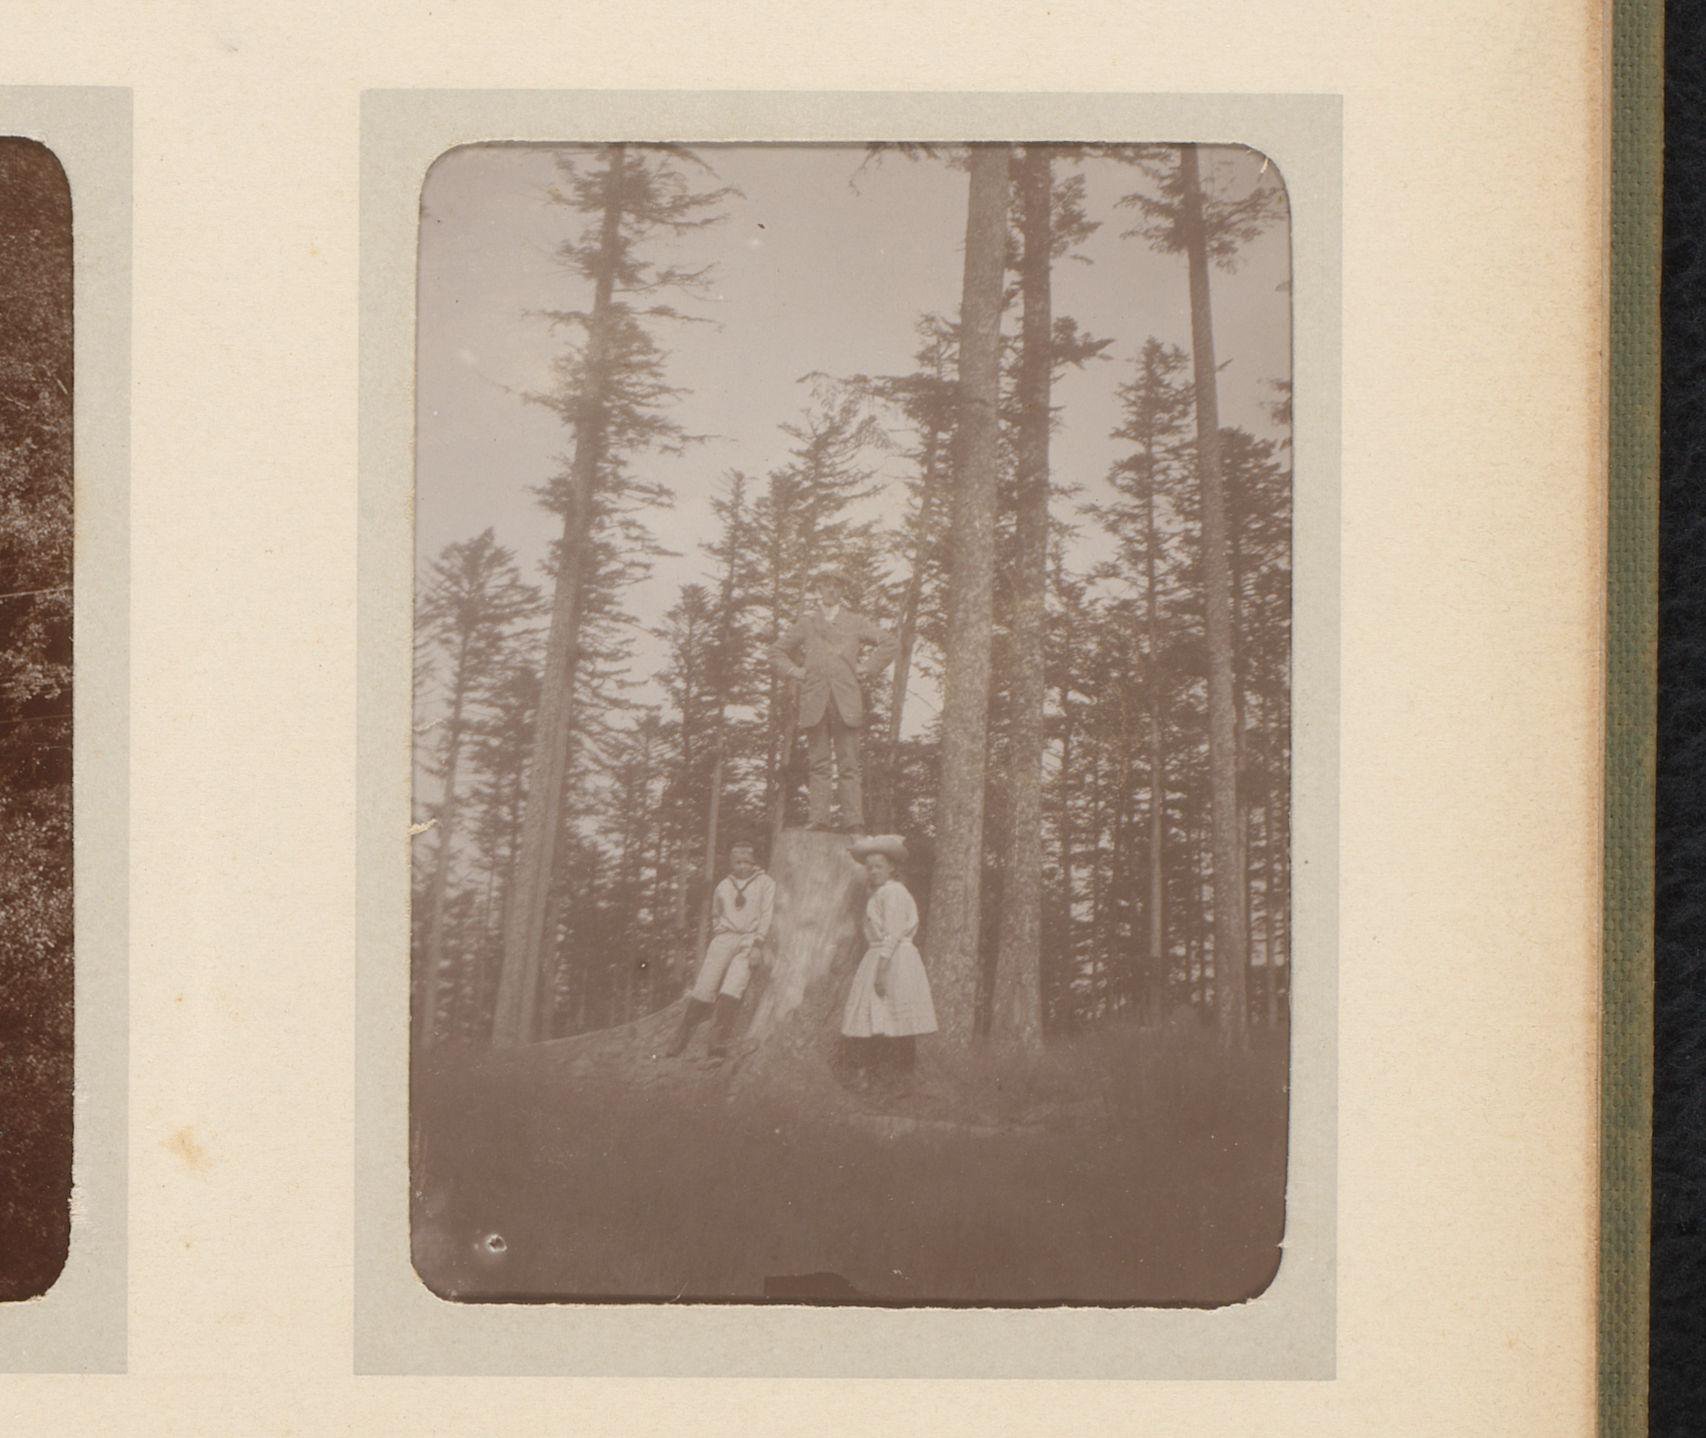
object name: photograph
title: Man, jongen en meisje in een bos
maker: liesbeth overhoff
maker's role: fotograaf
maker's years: 1895-1969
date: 1910-1915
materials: paper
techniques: collodion silver print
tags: boy (child between toddler and youth), adult man, forest, wood